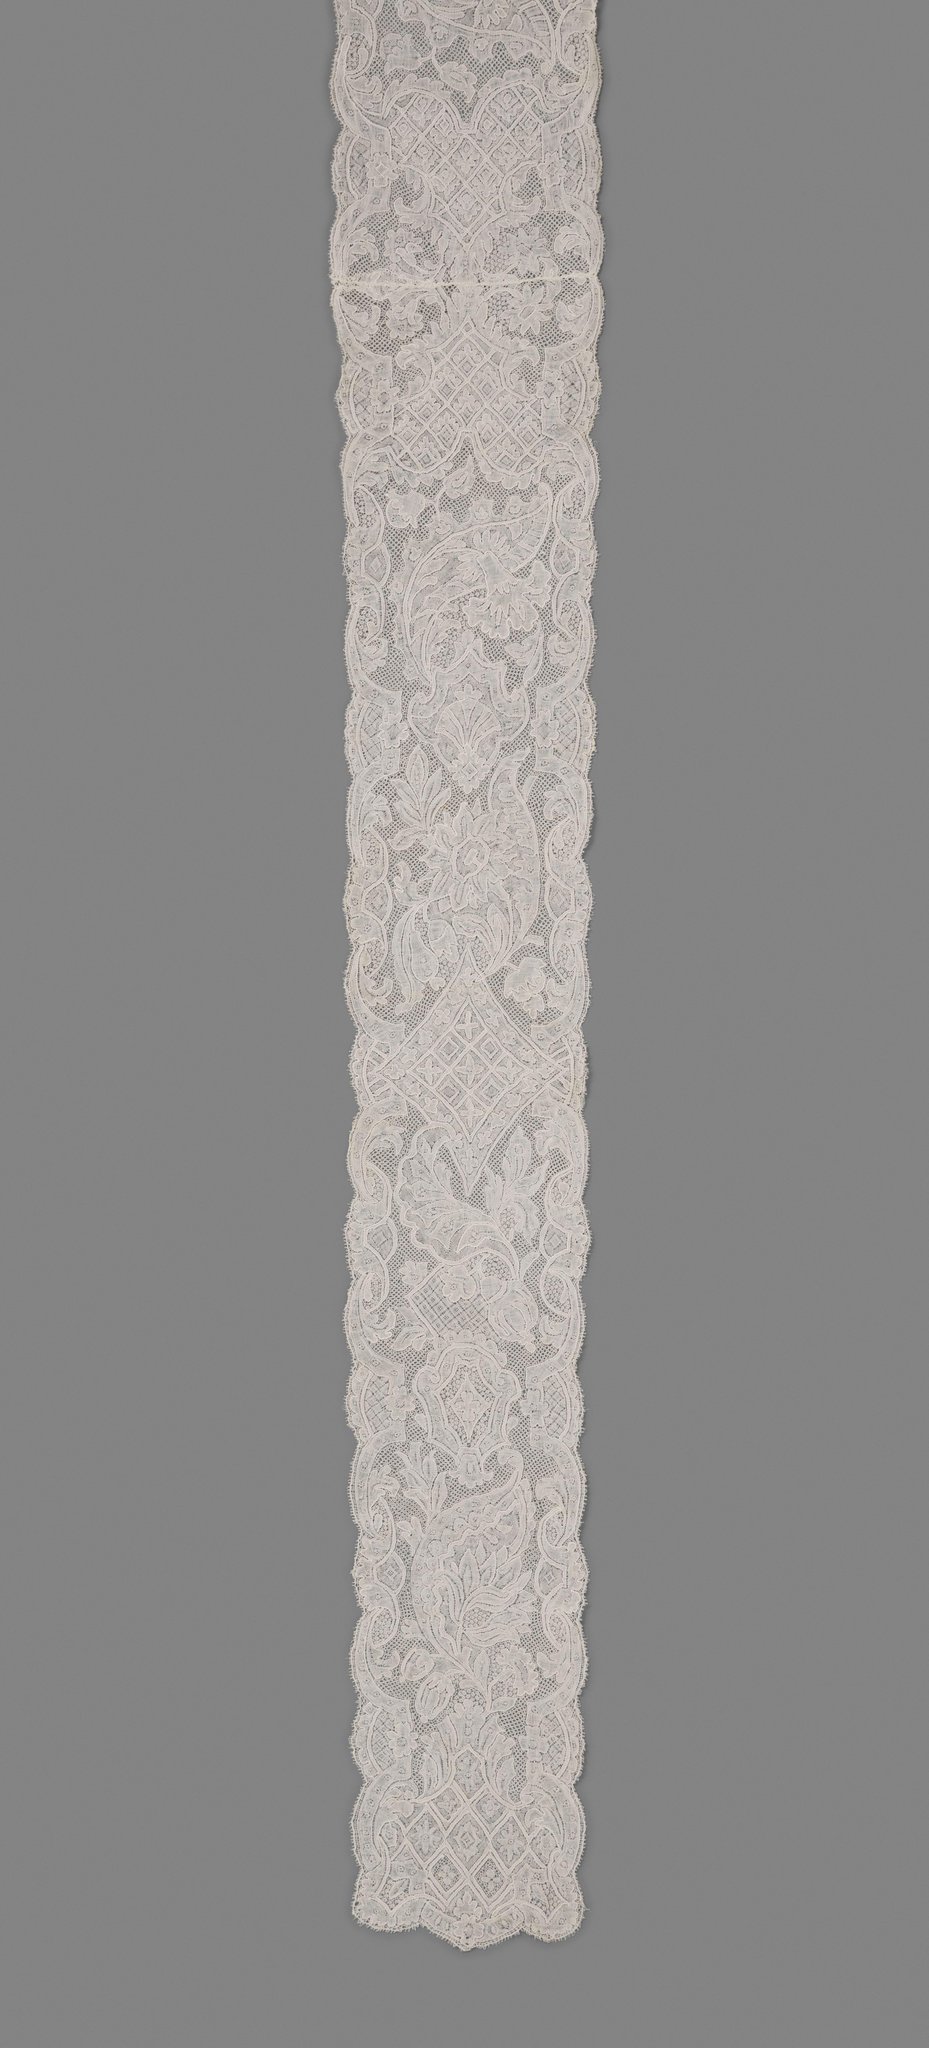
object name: lappet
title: Mutsenslippen van Mechelse kant, aaneengenaaid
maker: Anonymous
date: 1720-1730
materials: linen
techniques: lace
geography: mechelen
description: Twee aan elkaar genaaide mutsenslippen van kloskant. Het patroon bestaat uit met ruitwerk gevulde motieven die worden afgewisseld met bloemen, bladeren en vruchten. De geschulpte rand is afgezet met picots.